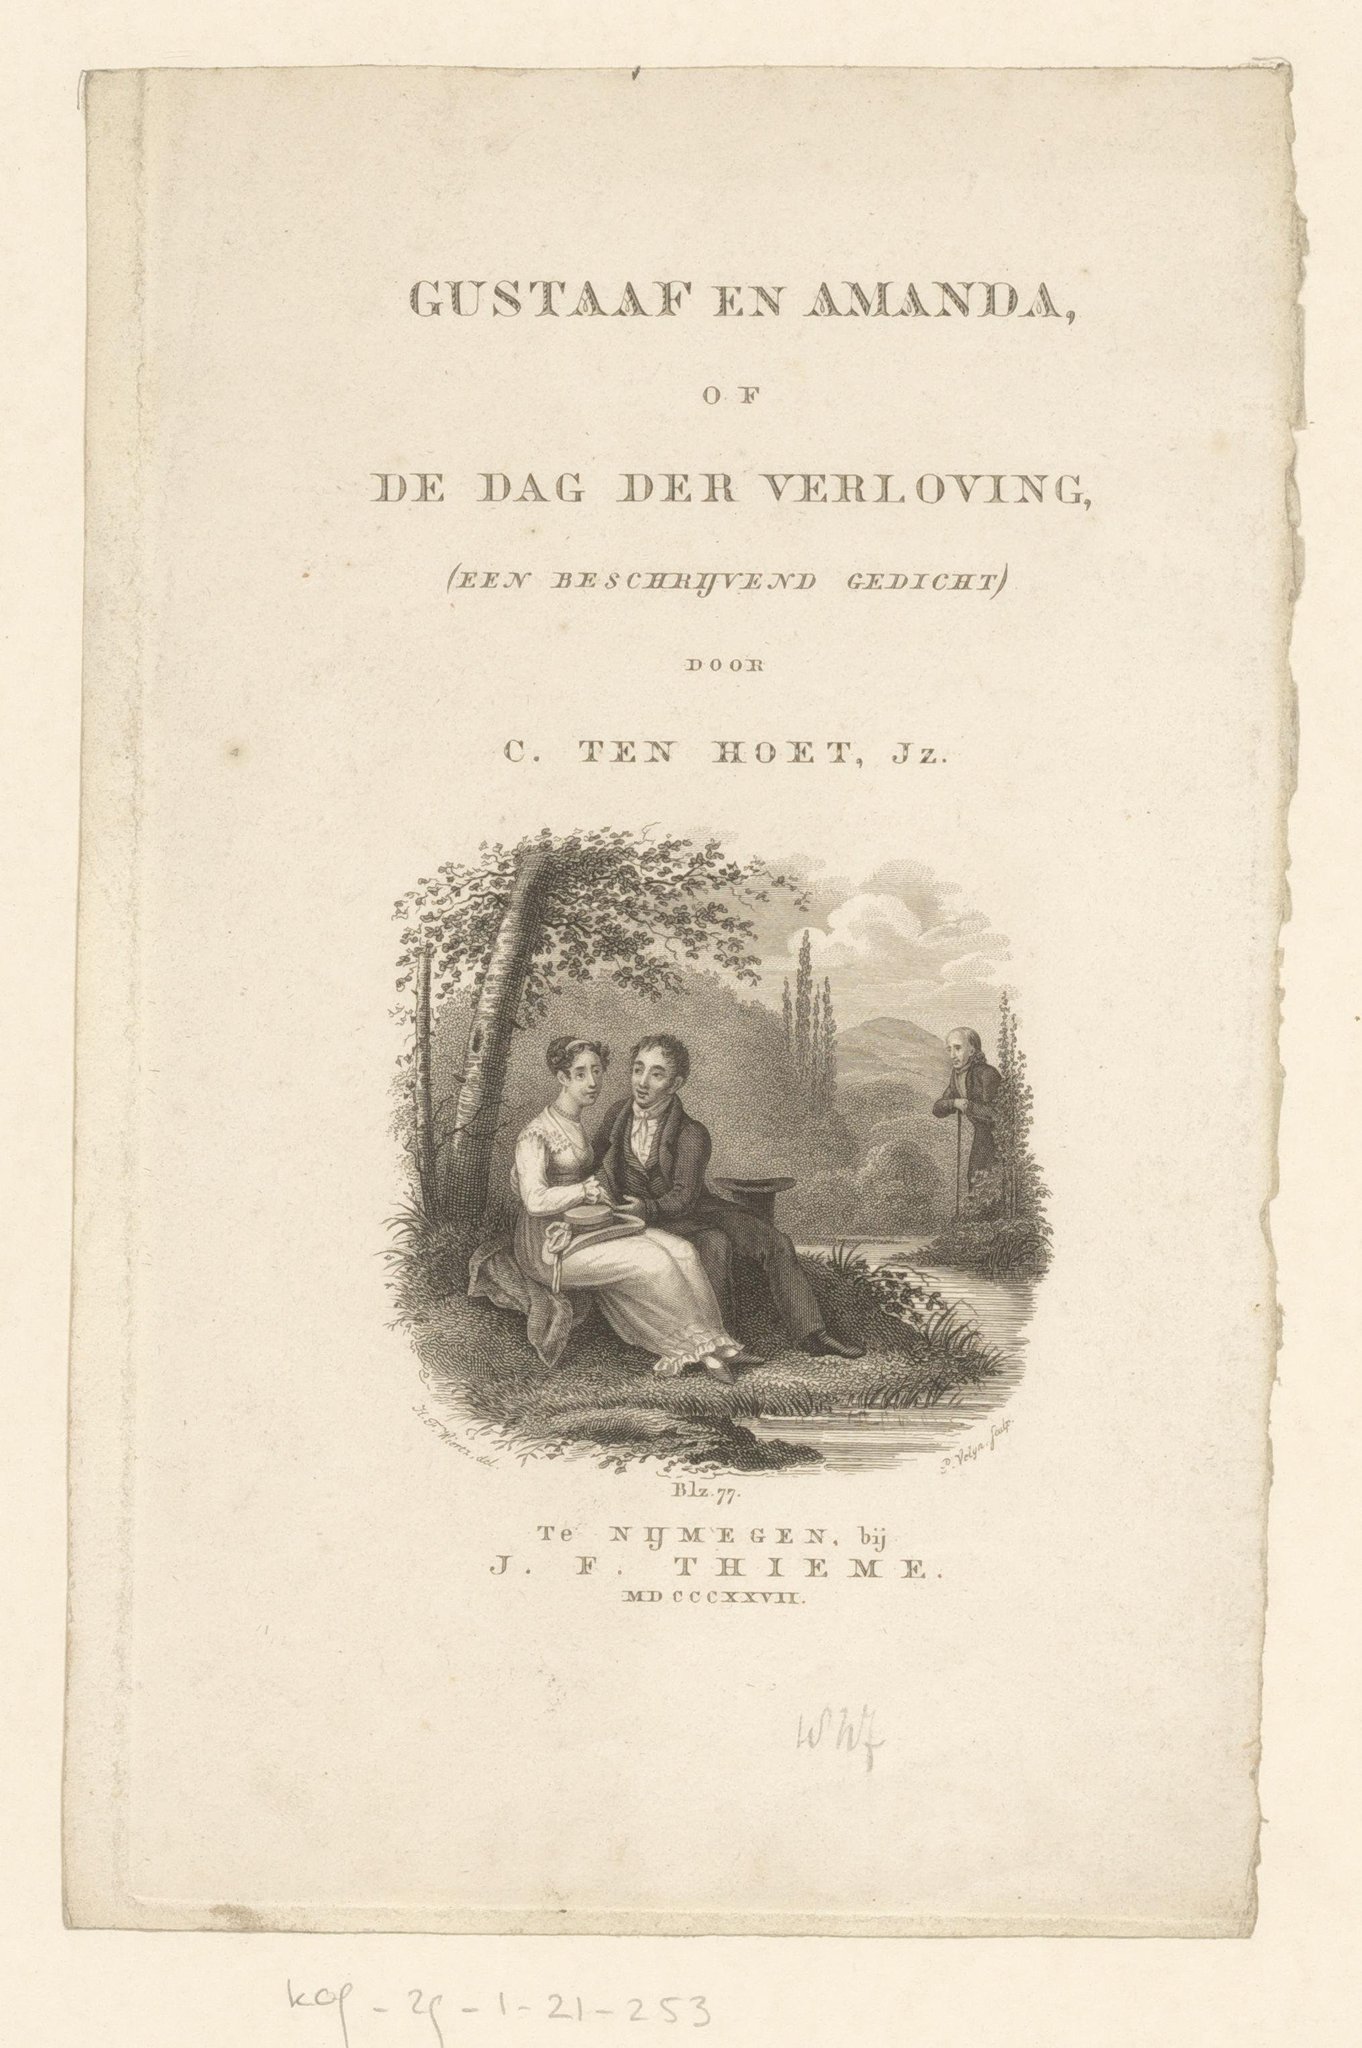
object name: titelprent, frontispice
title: Koppel zit aan een rivier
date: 1827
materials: paper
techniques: etching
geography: nijmegen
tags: river, couple of lovers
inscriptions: stamp, collector's mark: Lugt 1641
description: Onderwerpsrubrieken binnen de Atlas Zeden en Gewoonten: Zeden en Gewoonten in Engeren Zin, De Kleeding, Kleederdrachten (tijdvakken), De regeering van Willem I. Mannen en vrouwen.